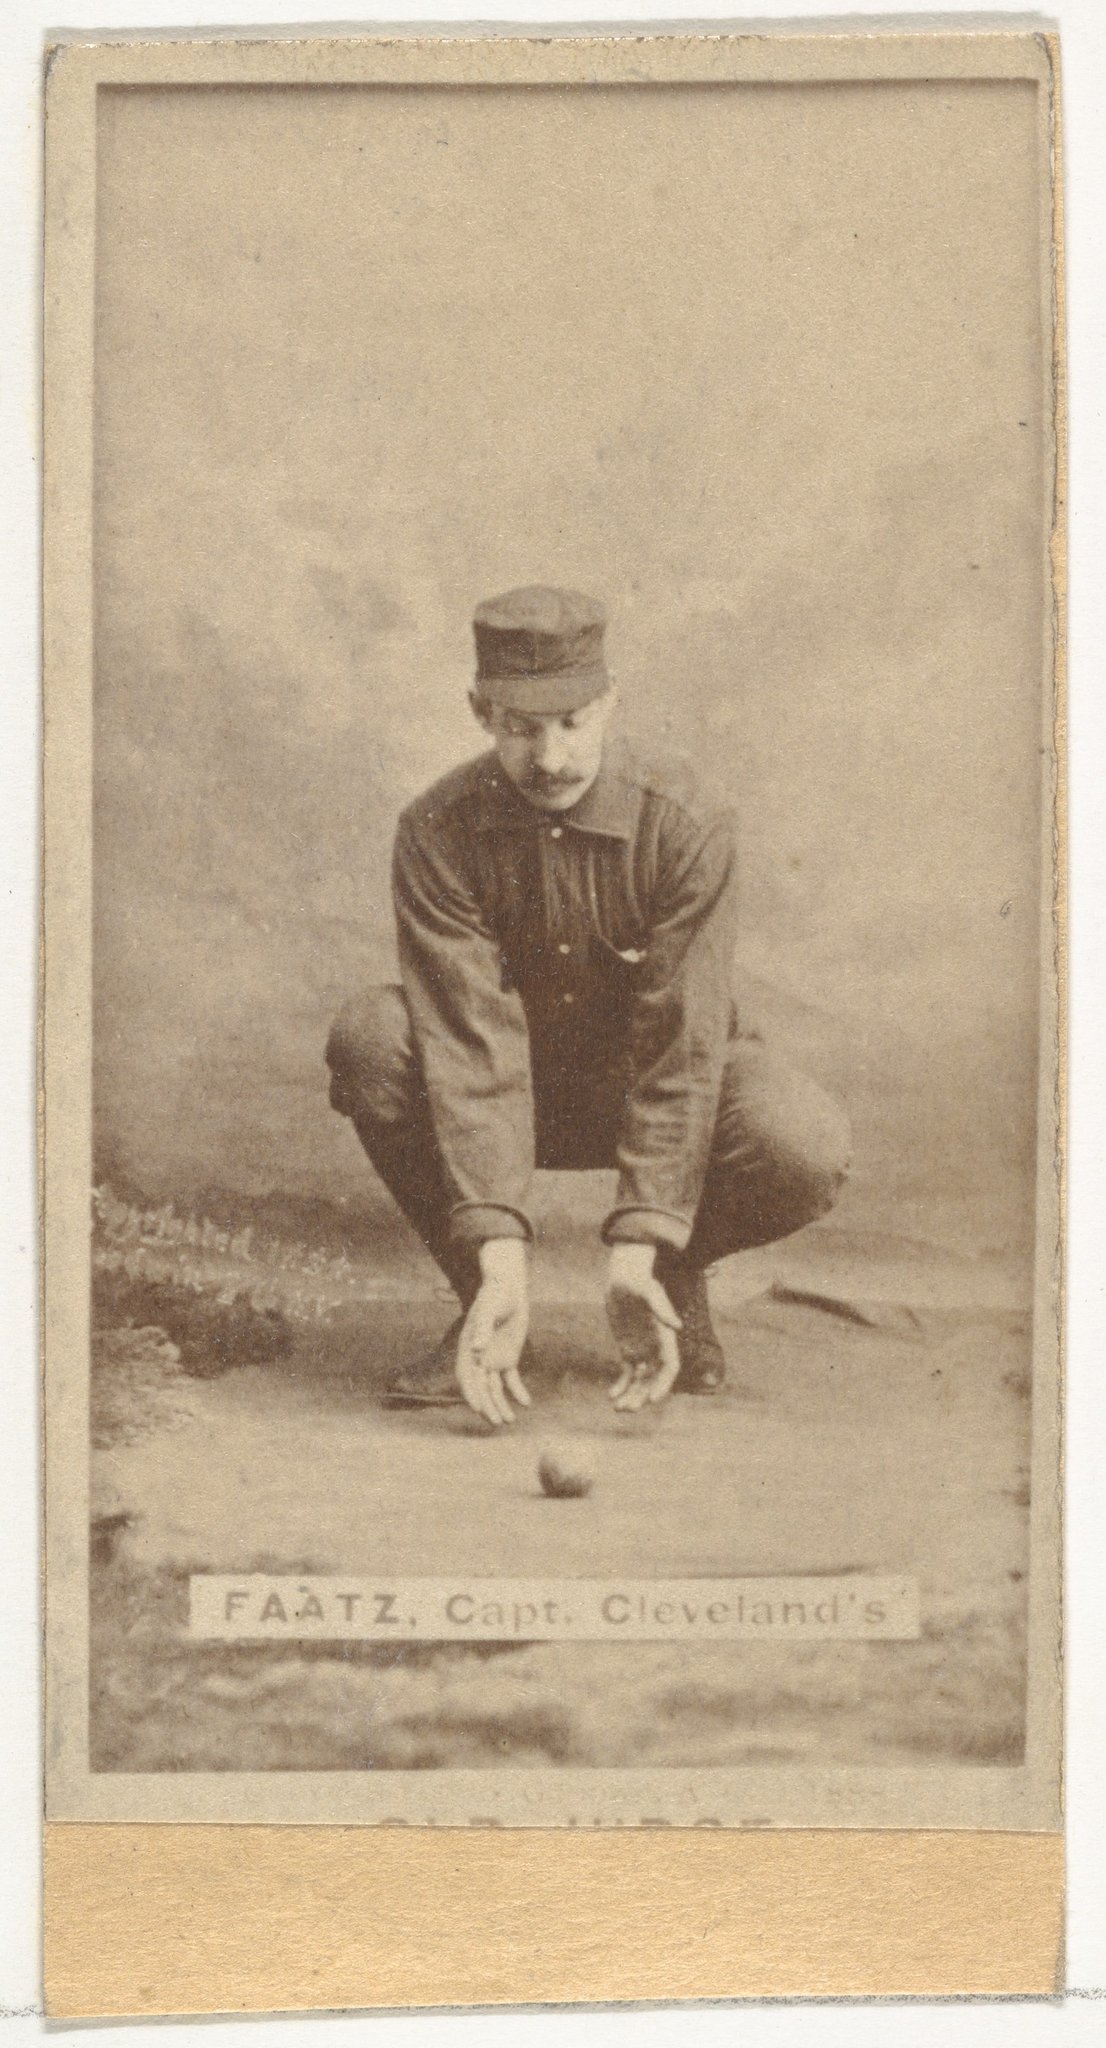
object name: baseball card, photograph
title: Jayson S. "Jay" Faatz, Captain, Cleveland, from the Old Judge series (N172) for Old Judge Cigarettes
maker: goodwin & company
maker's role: publisher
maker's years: 1850-1950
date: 1888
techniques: albumen silver print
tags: men,portraits,baseball,athletes